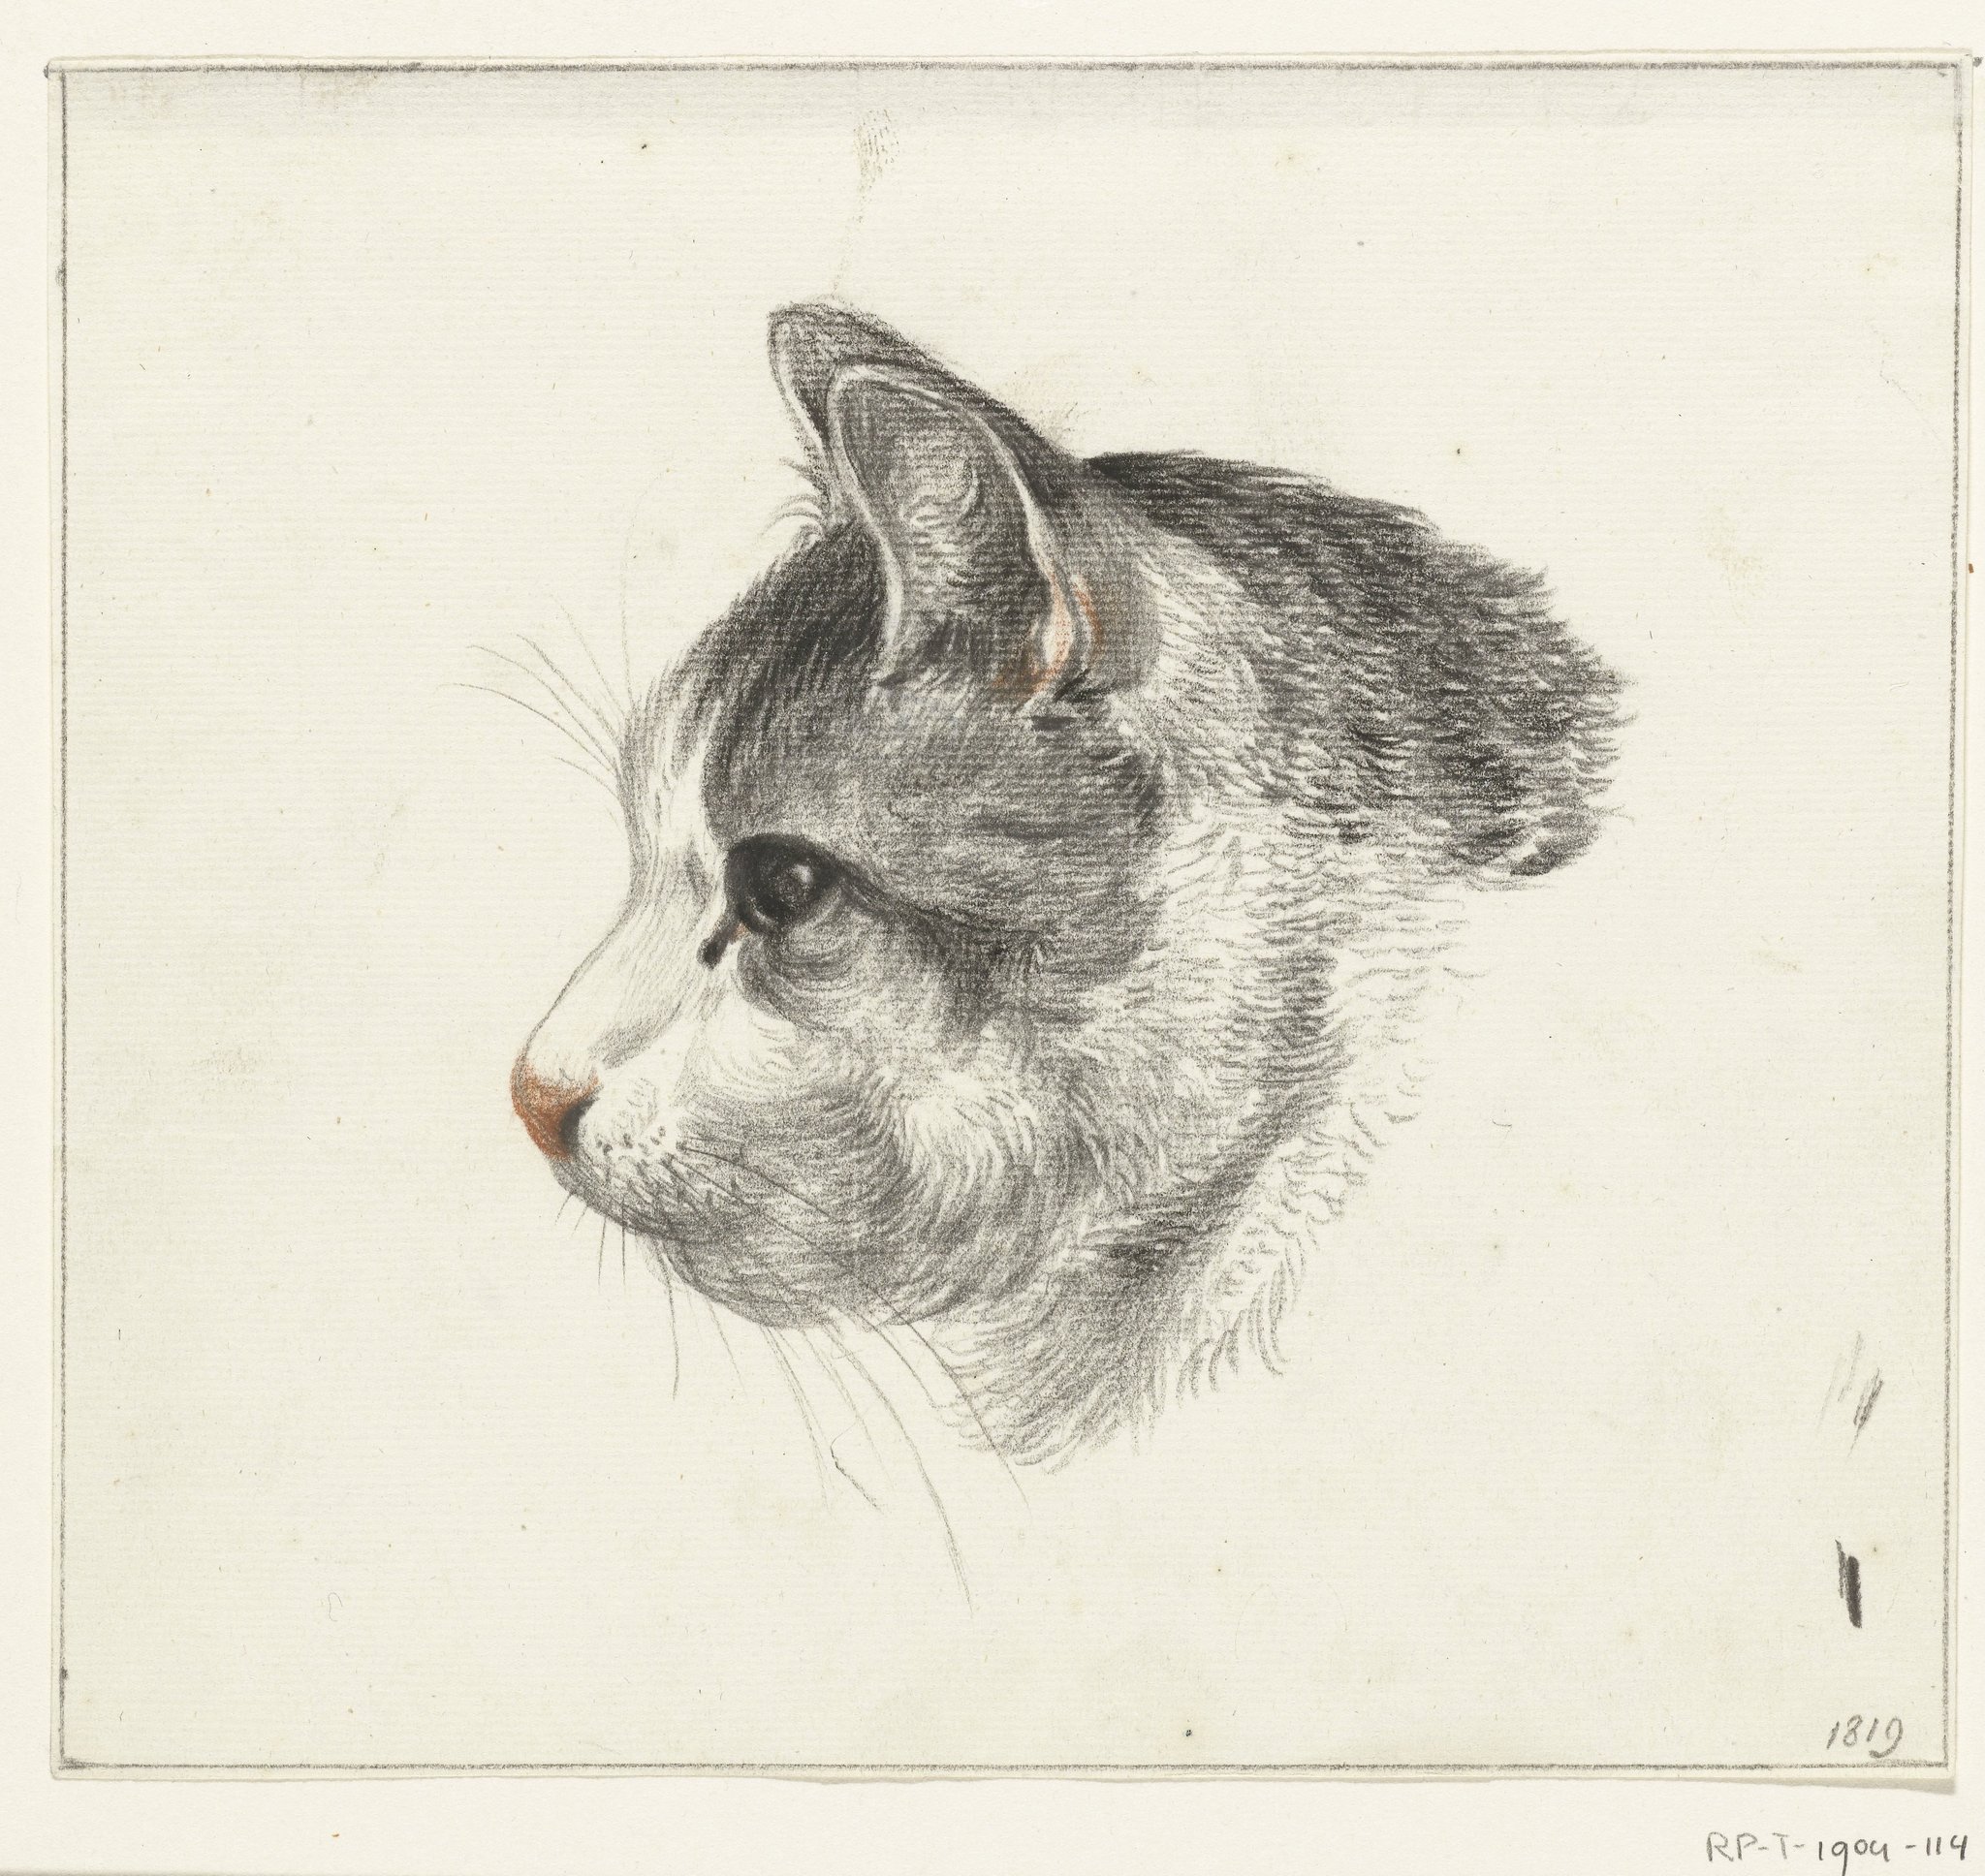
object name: drawing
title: Kop van een kat, naar links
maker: jean bernard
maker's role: draughtsman, print maker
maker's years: 1765-1833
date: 1819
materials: chalk, paper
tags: cat